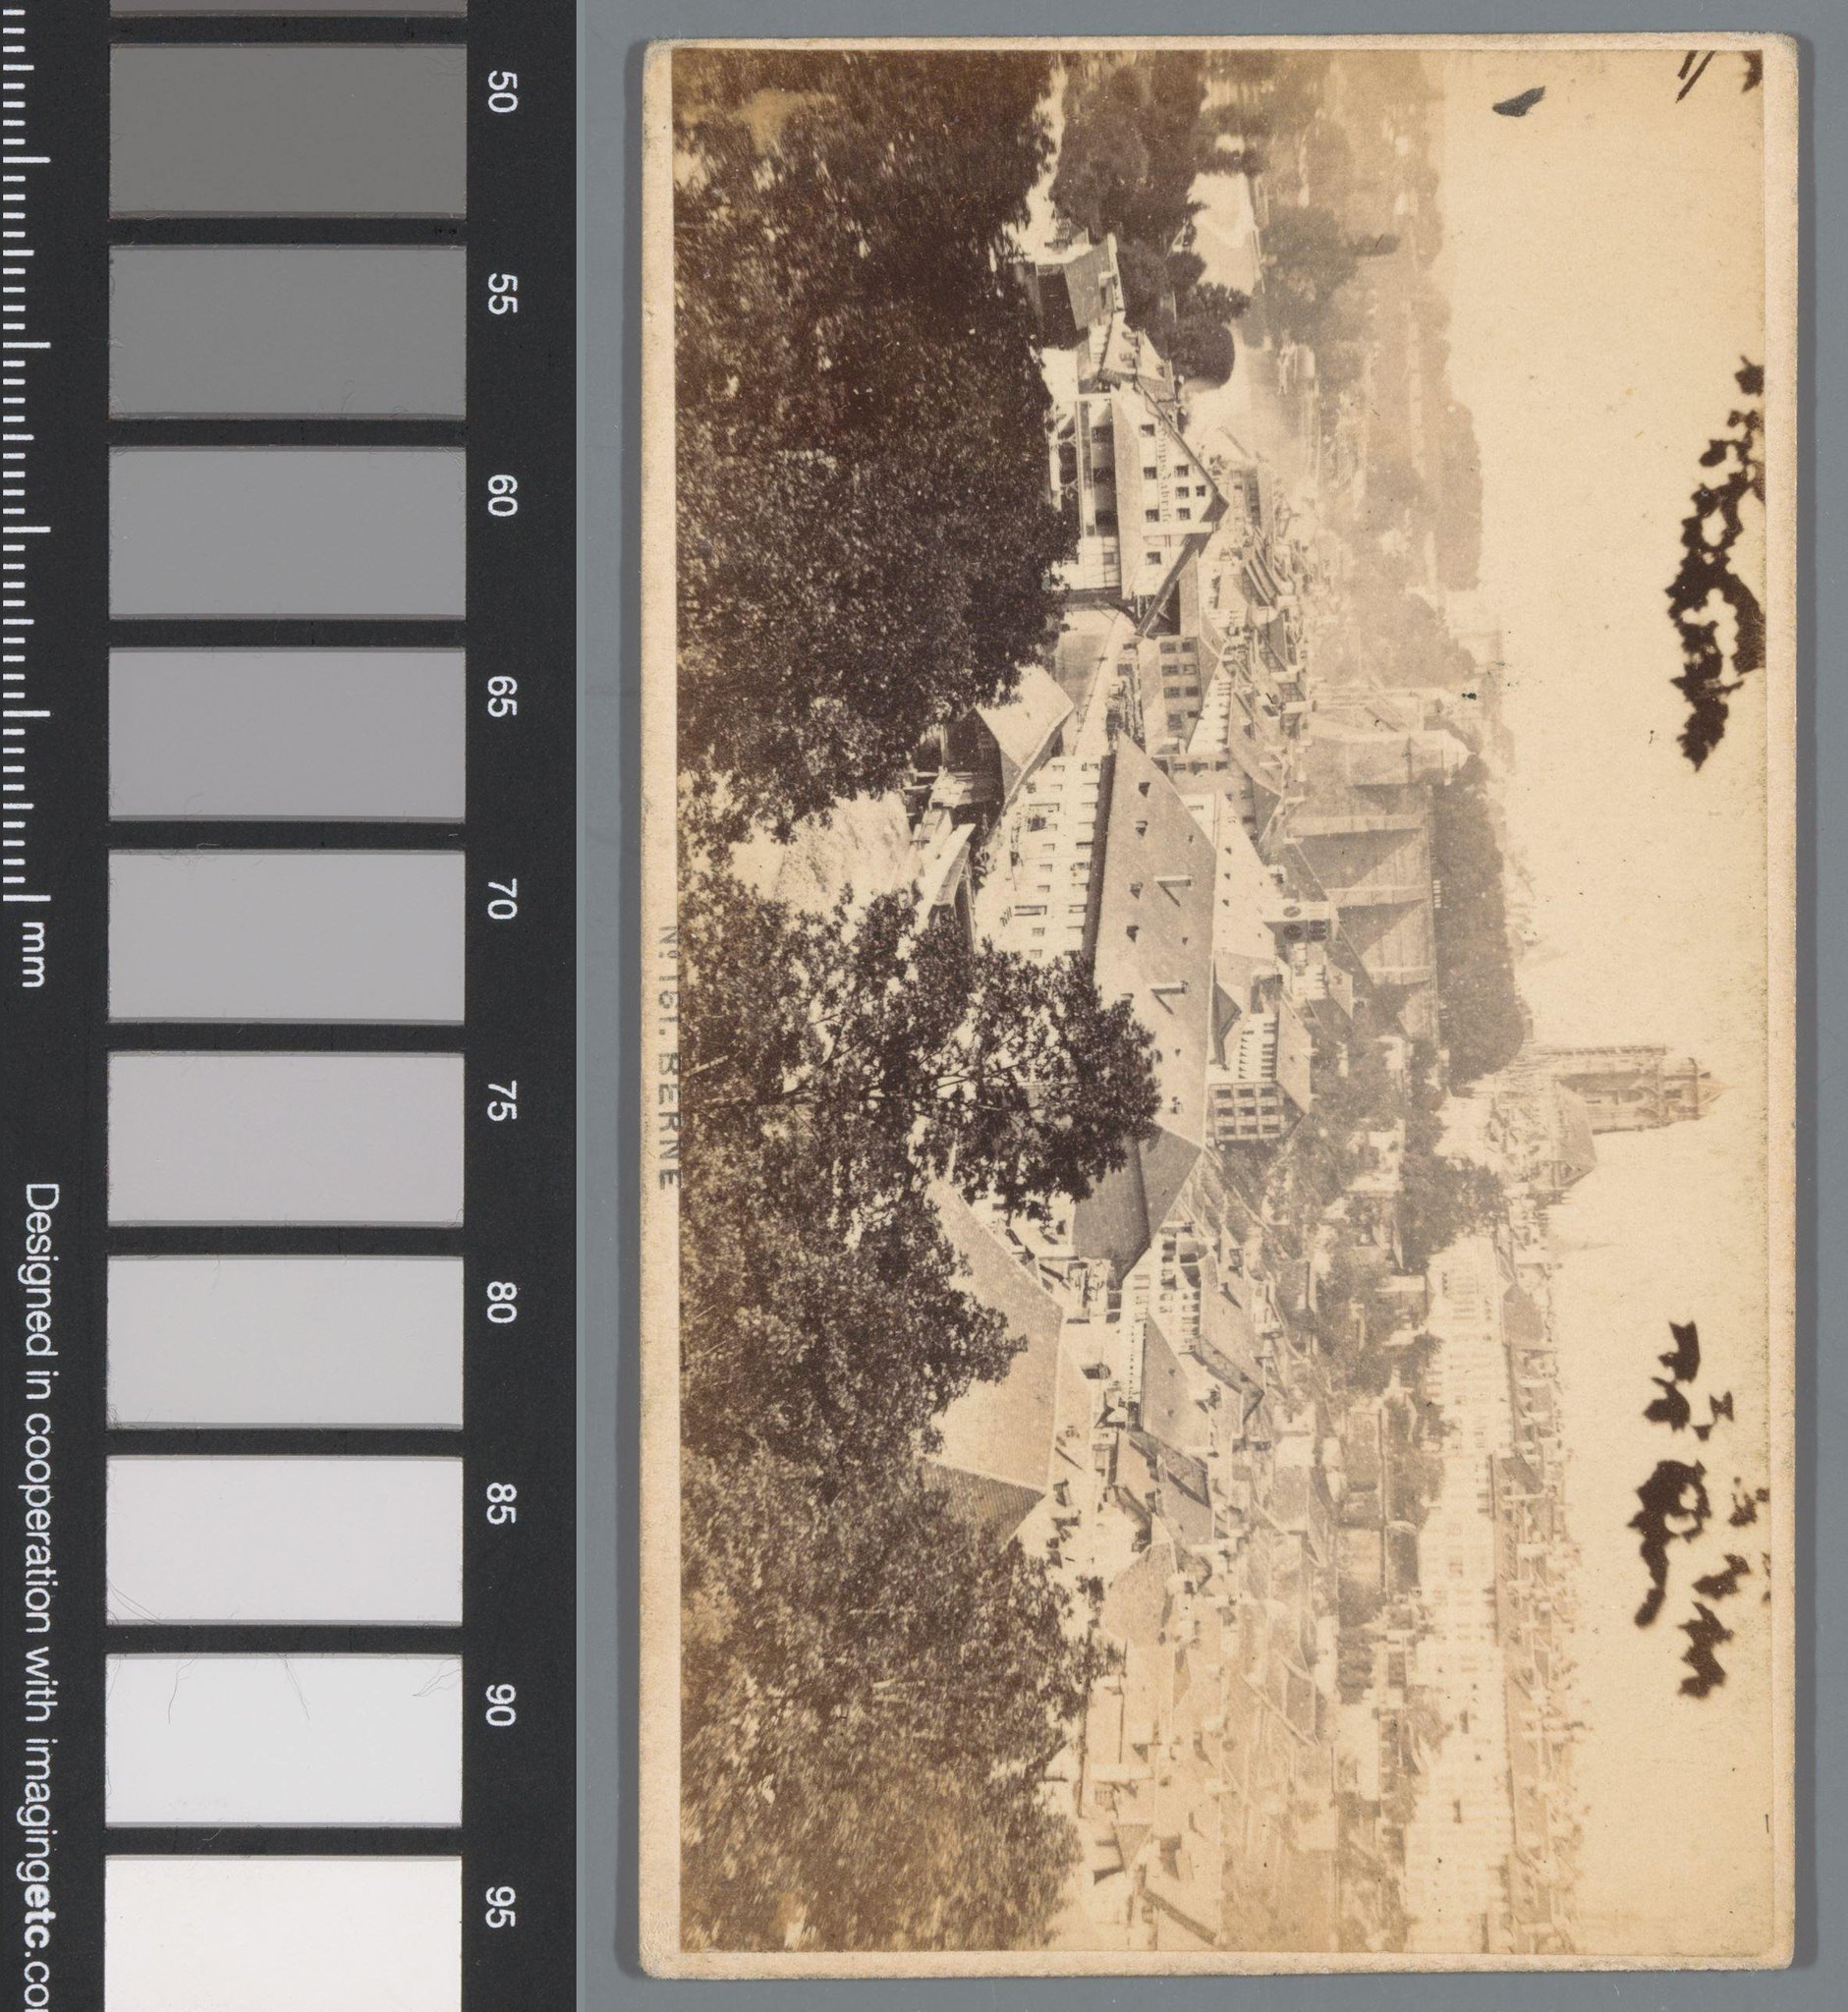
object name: photograph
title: Berne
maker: florentin charnaux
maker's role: publisher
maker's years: 1819-1883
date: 1850-1883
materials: cardboard, paper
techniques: albumen print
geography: bern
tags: city-view in general; 'veduta'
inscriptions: inscription: ‘Maison des Trois Rois/ F. Charnaux/ Genève’, inscription: ‘No. 123 Berne.’, number: ‘No 161’